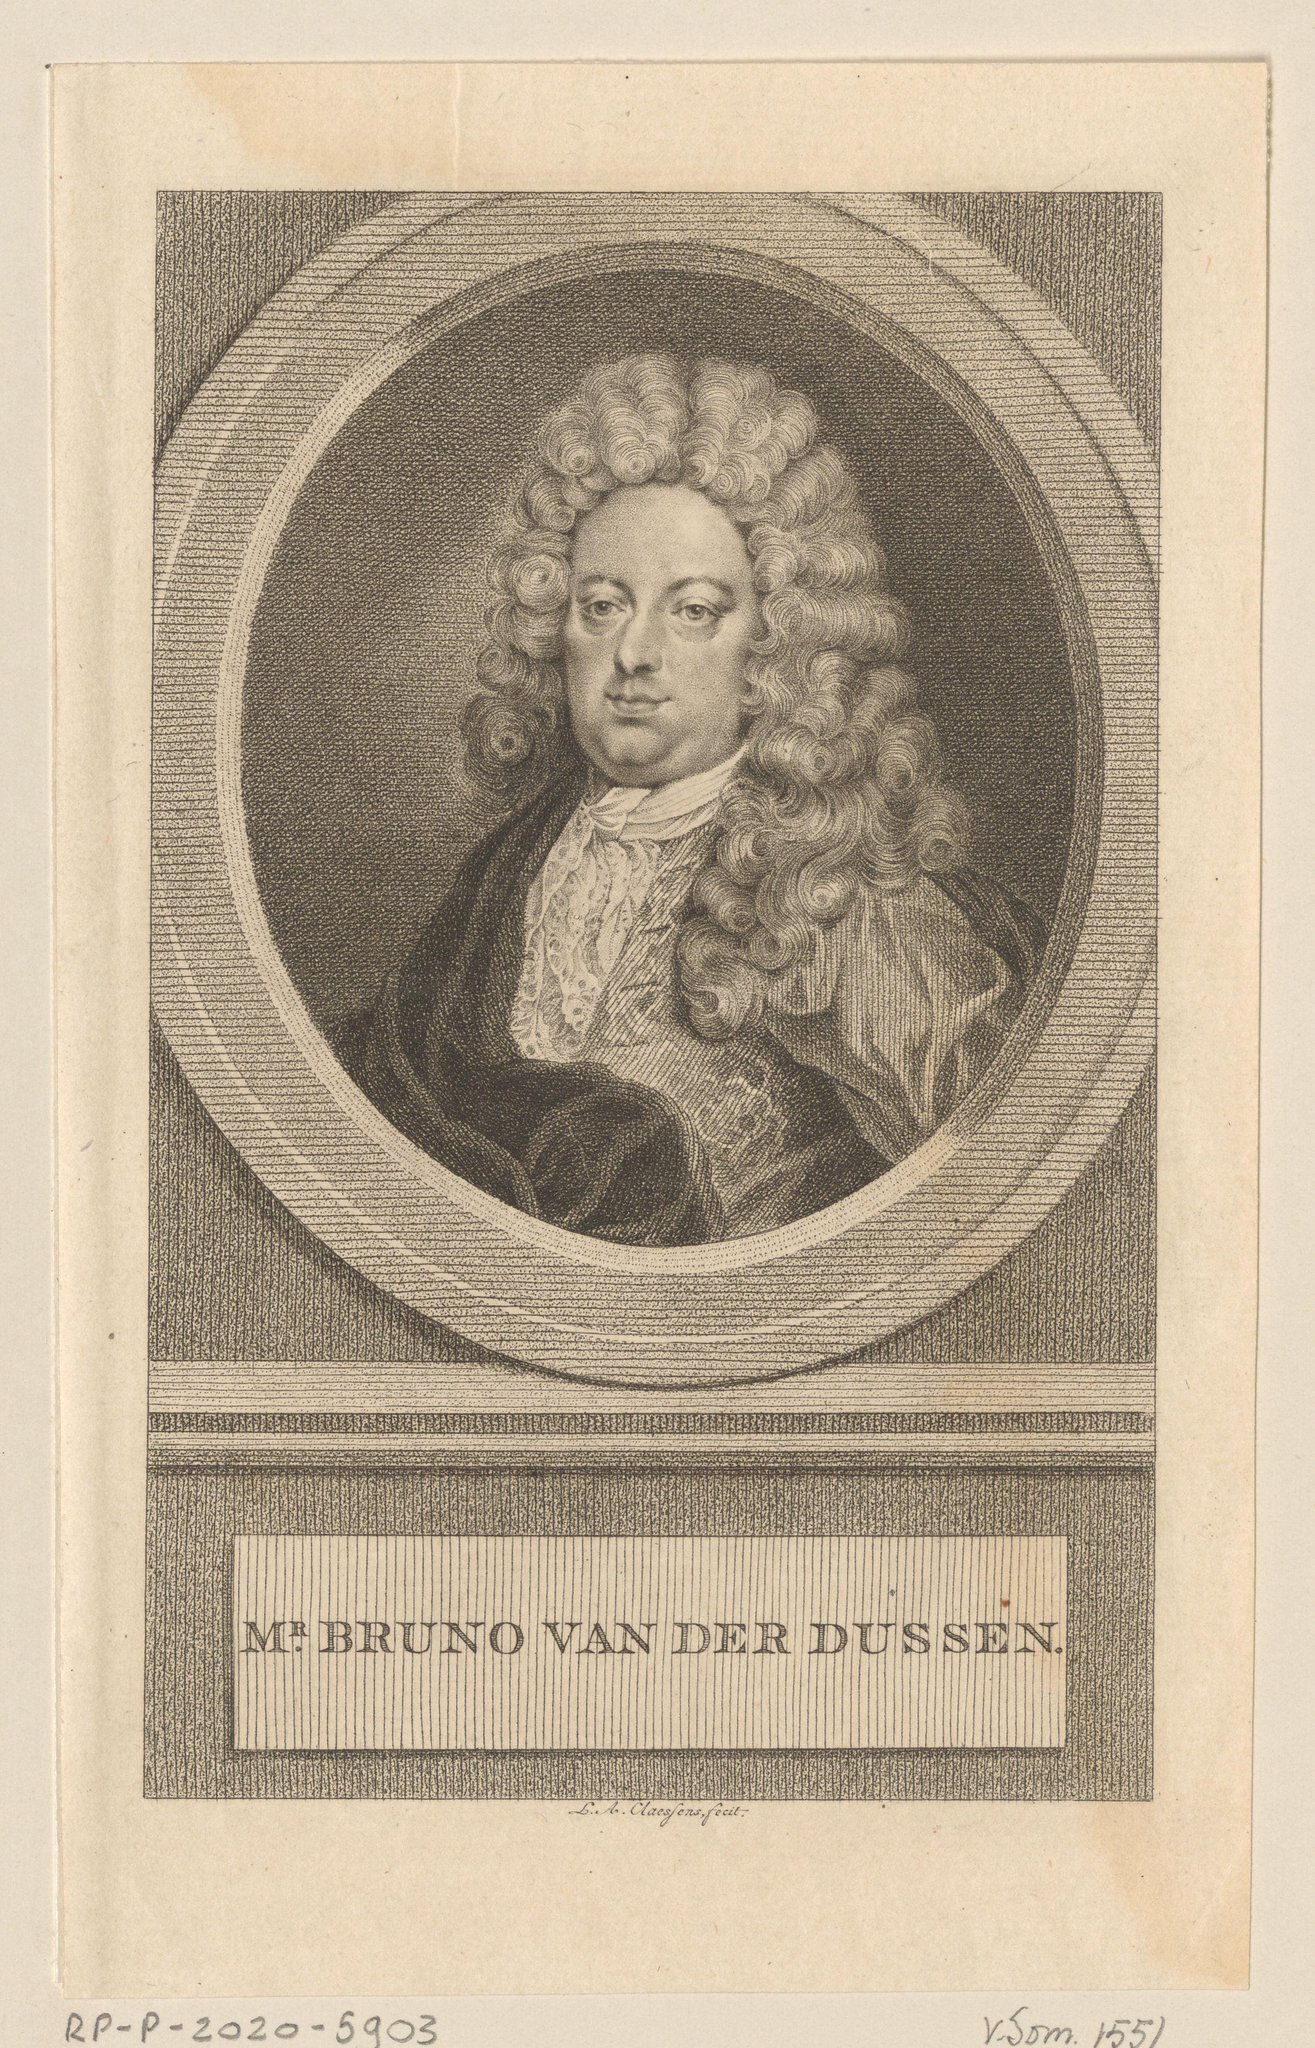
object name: print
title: Portret van Bruno van der Dussen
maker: lambertus antonius claessens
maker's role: draughtsman, print maker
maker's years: 1763-1834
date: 1795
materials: paper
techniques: engraving, etching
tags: mayor, bruno van der dussen, mayor, burgomaster, historical persons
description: Prent mogelijk uit: Wagenaar, Jan. Vaderlandsche historie, vervattende de geschiedenissen der nu Vereenigde Nederlanden (...). Amsterdam: Johannes Allart, 1795, dl. 17.